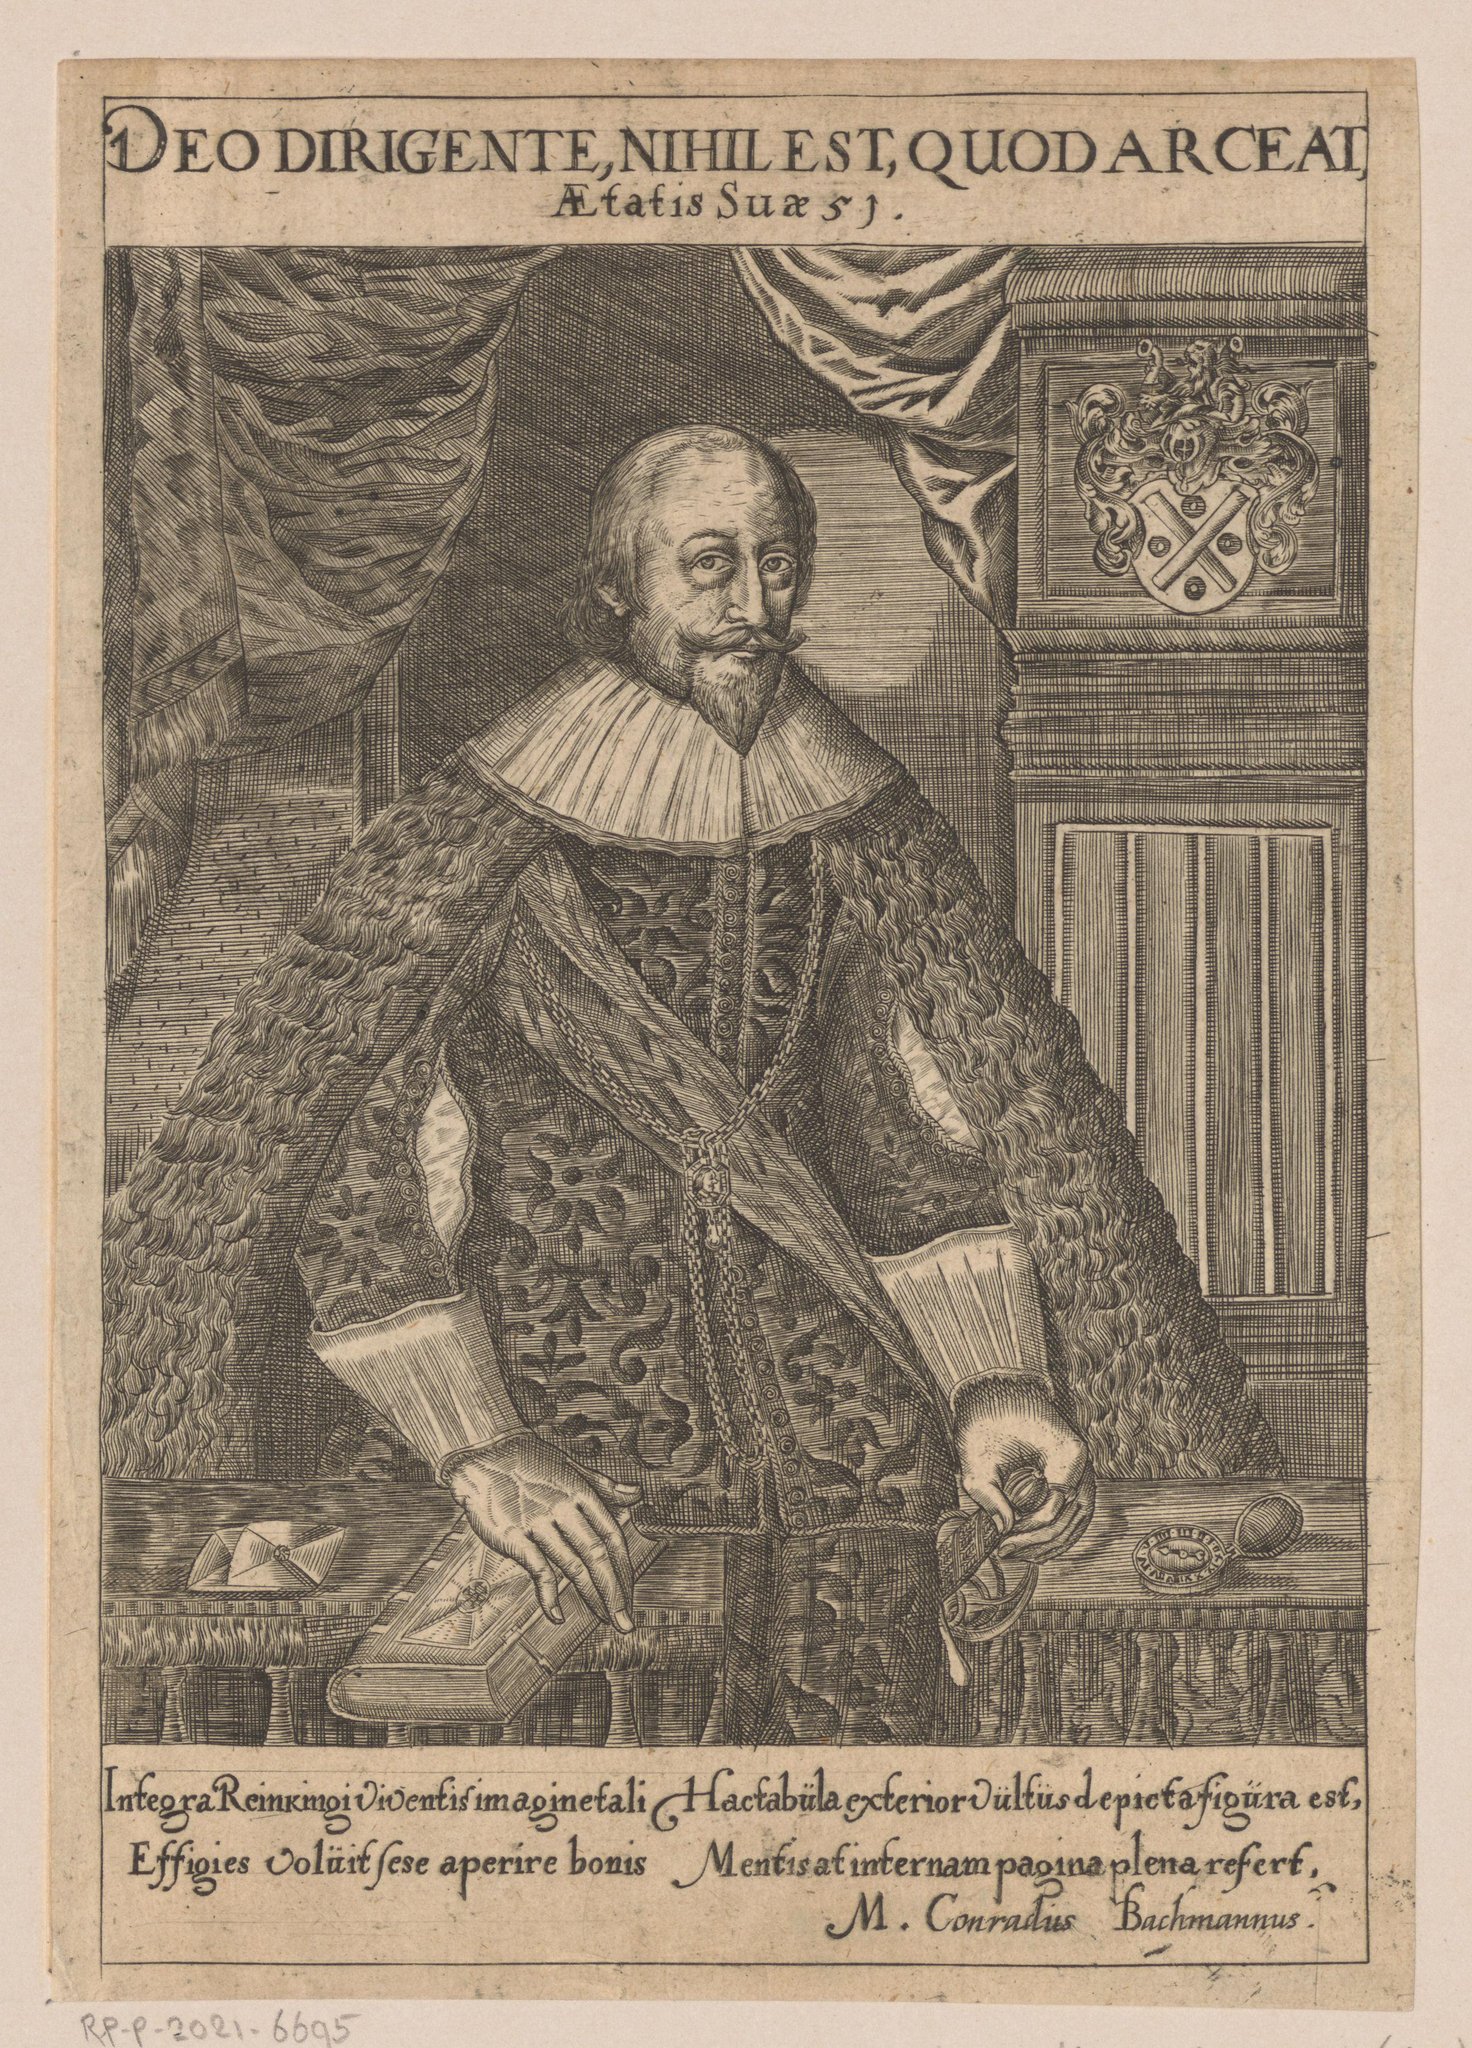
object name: print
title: Portret van Dietrich Reinkingk op 51-jarige leeftijd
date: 1641-1699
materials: paper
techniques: engraving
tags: politician, historical persons, hacking and thrusting weapons: sword, watch, armorial bearing, heraldry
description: Rechtsboven het portret zijn wapenschild.